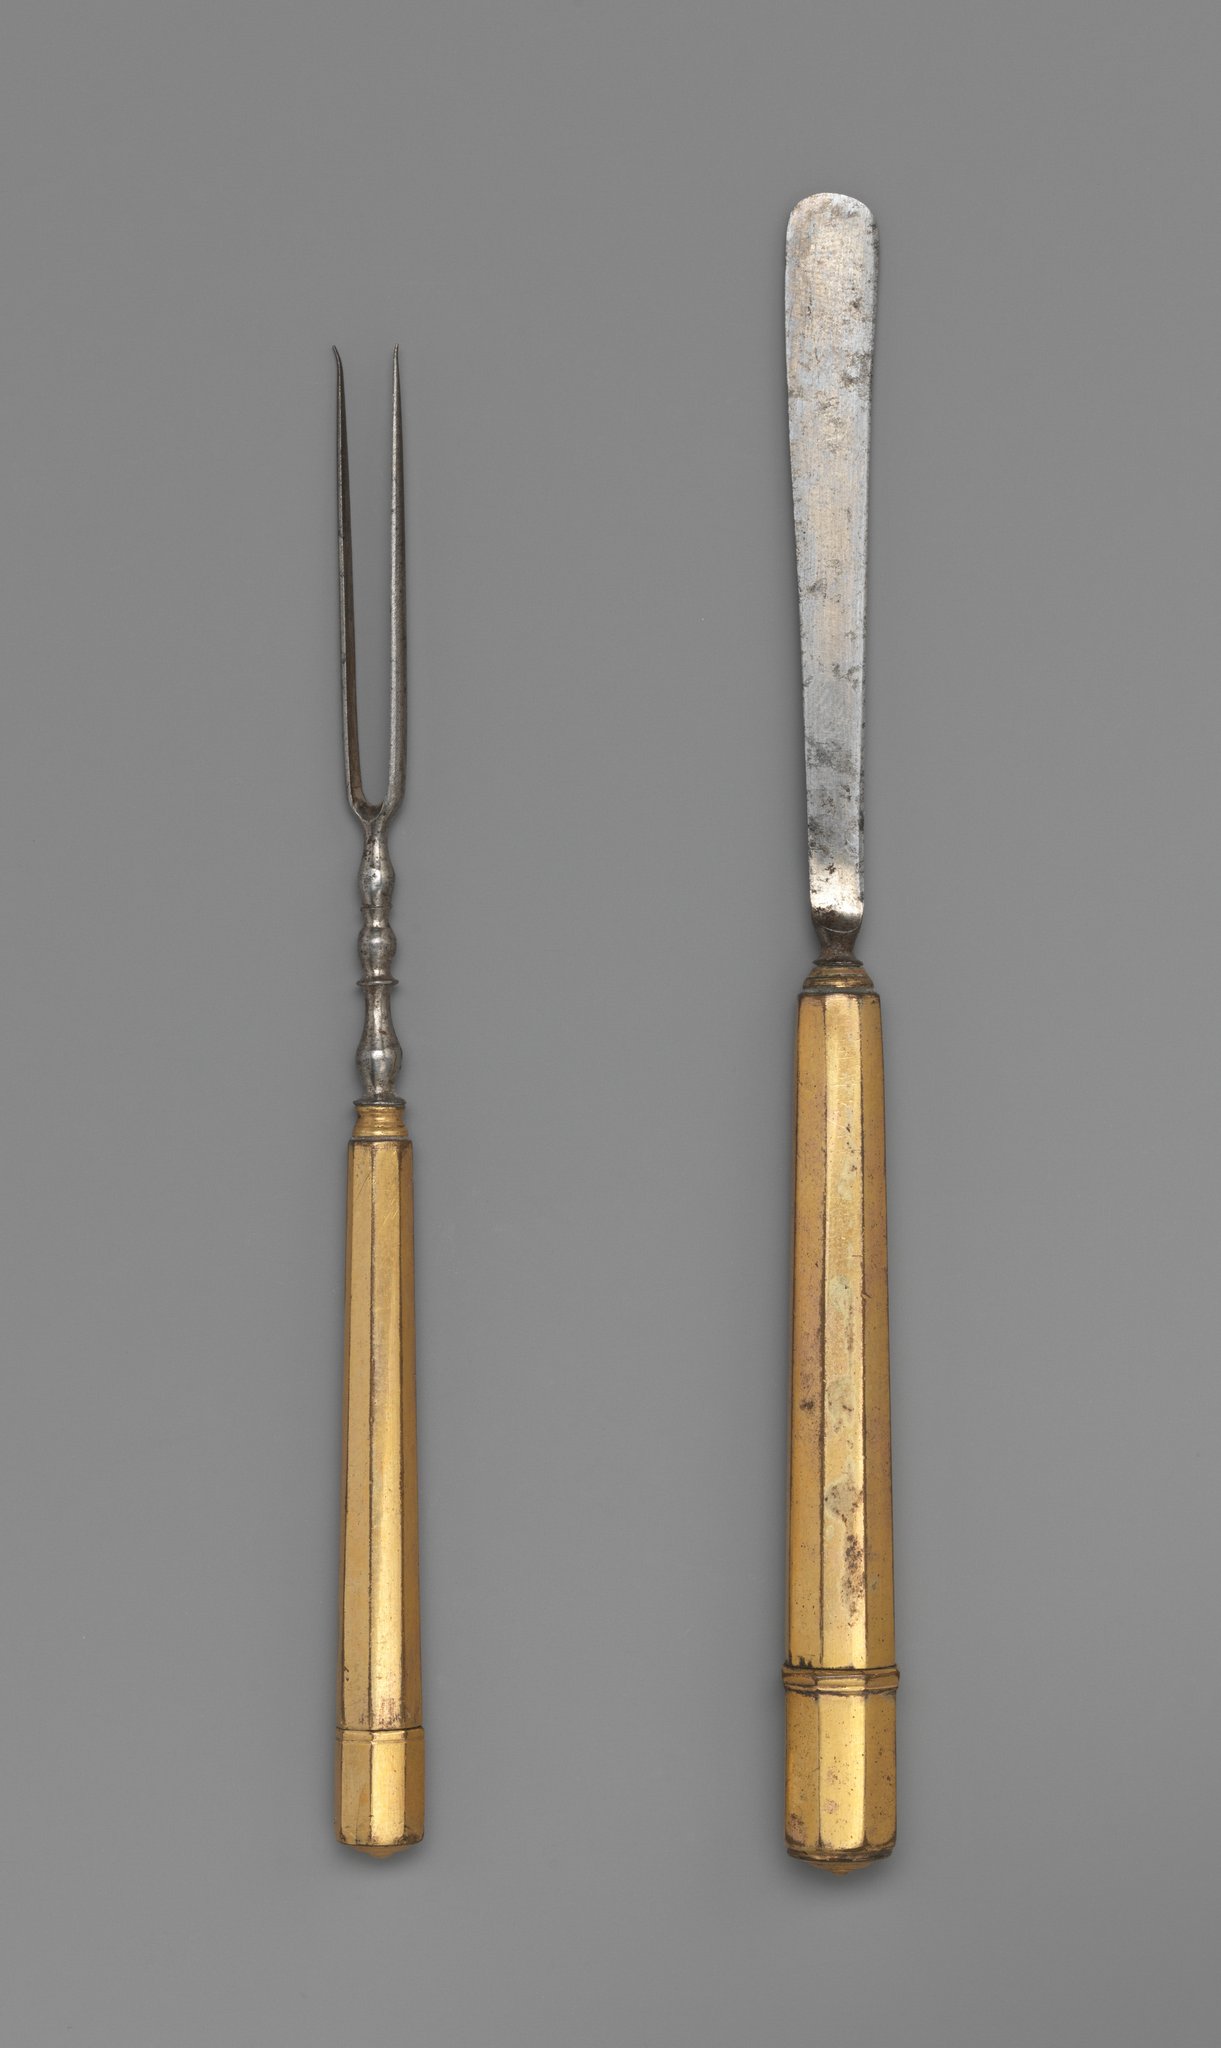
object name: fruit fork and knife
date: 1701-1800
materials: gilt copper, steel